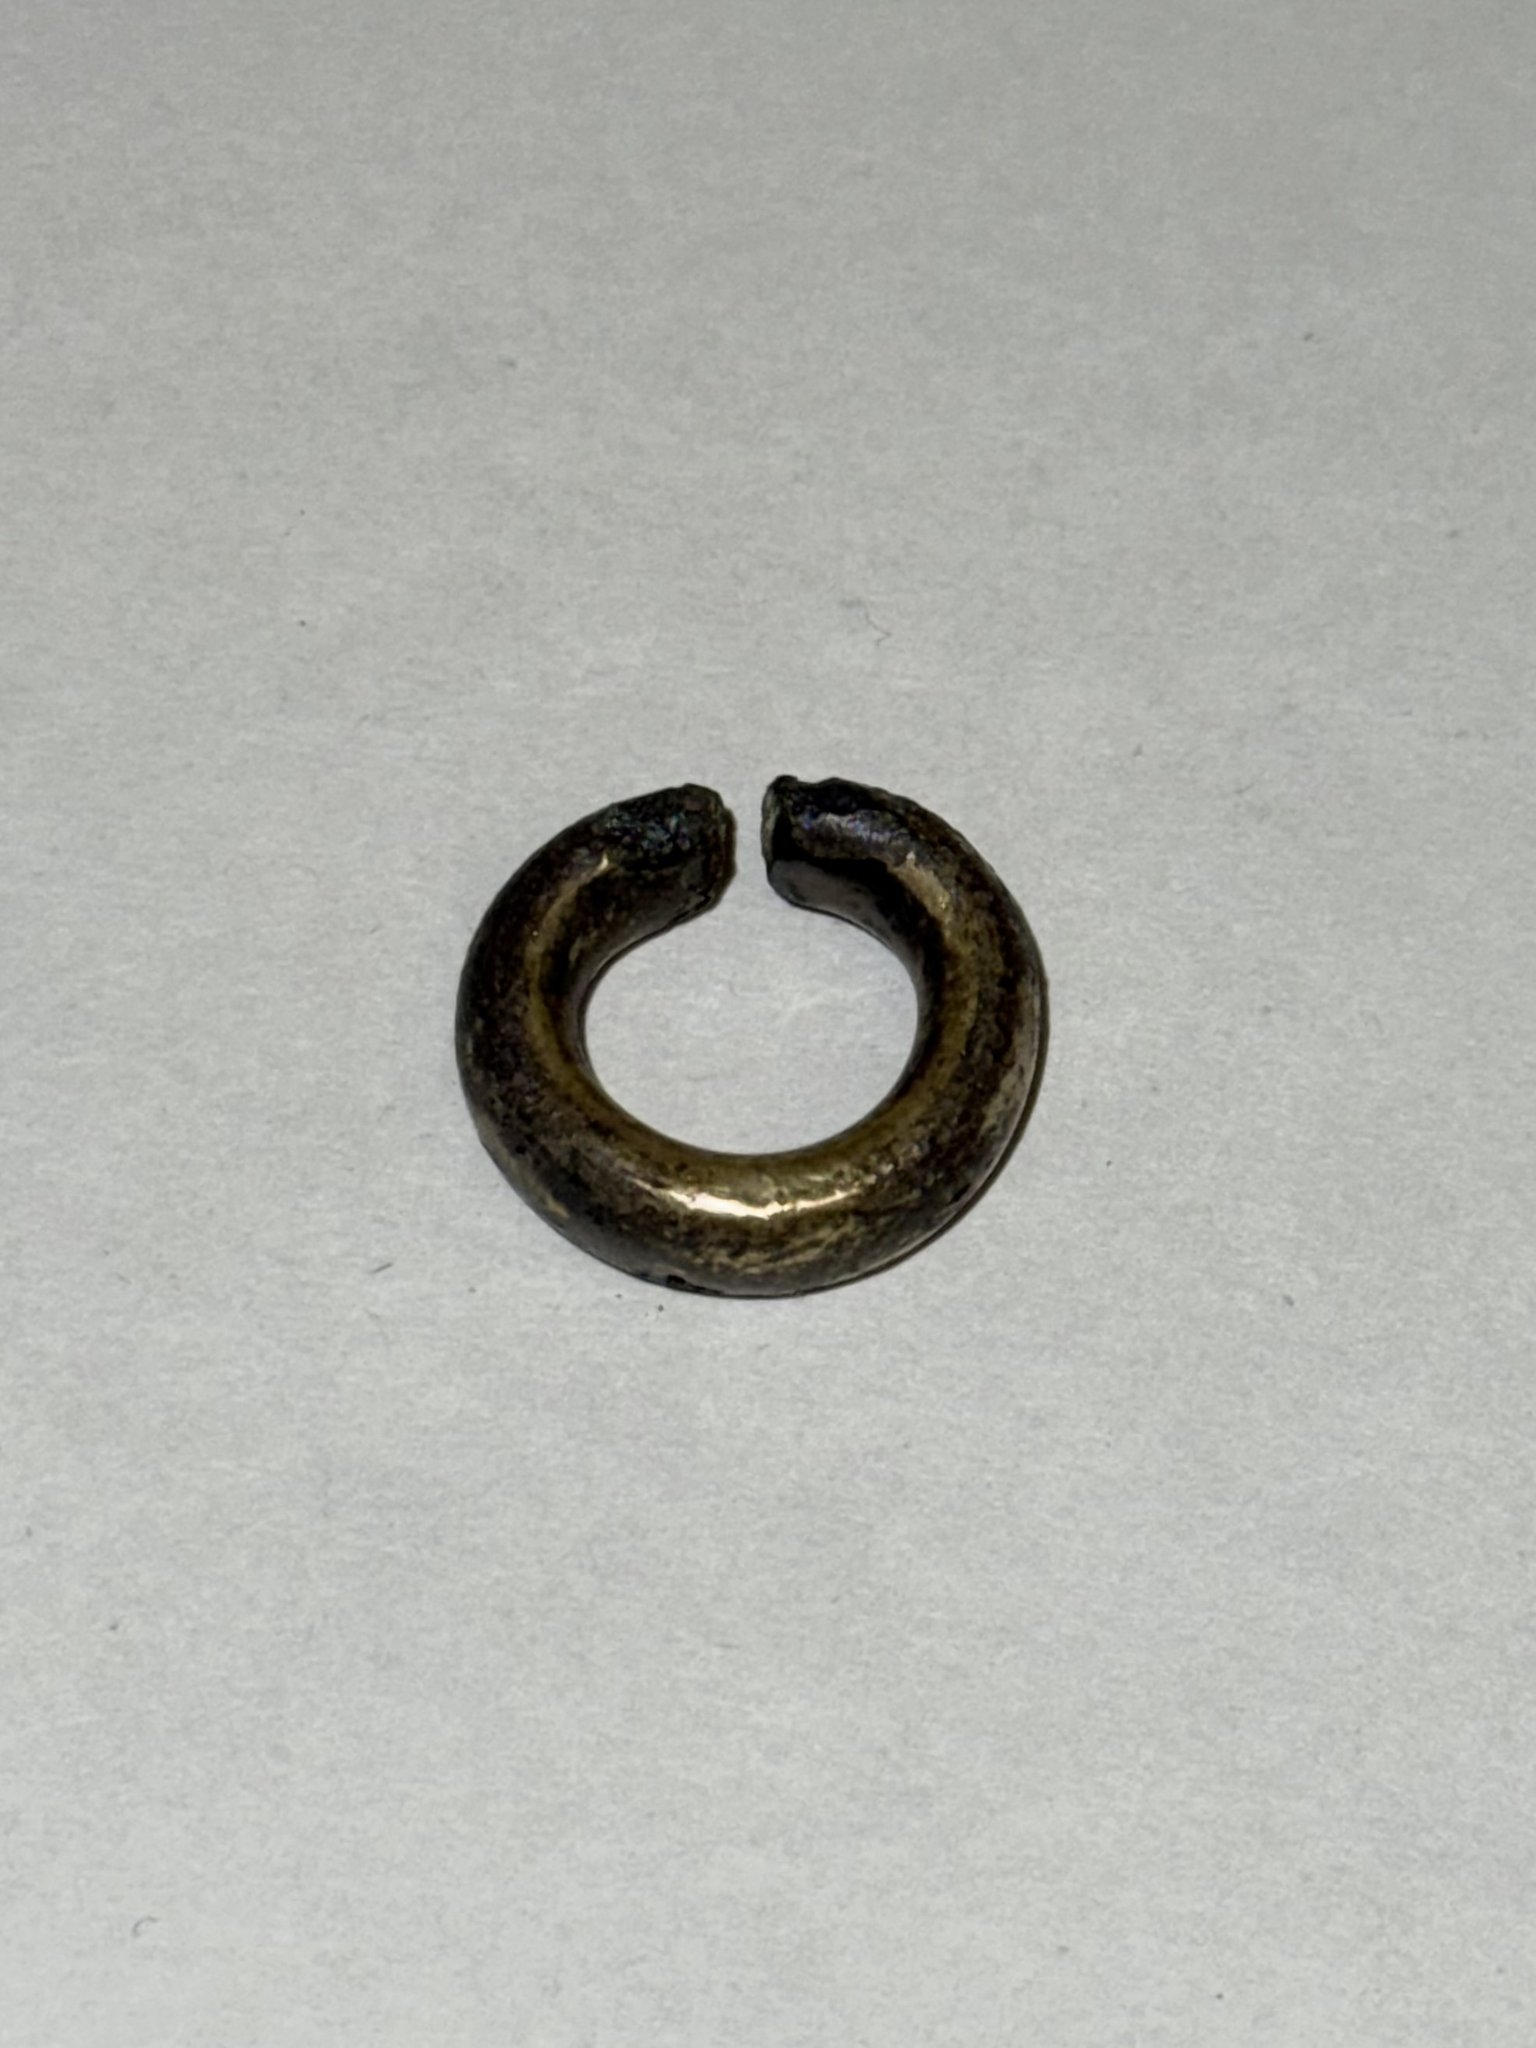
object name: earring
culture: japanese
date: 601-700